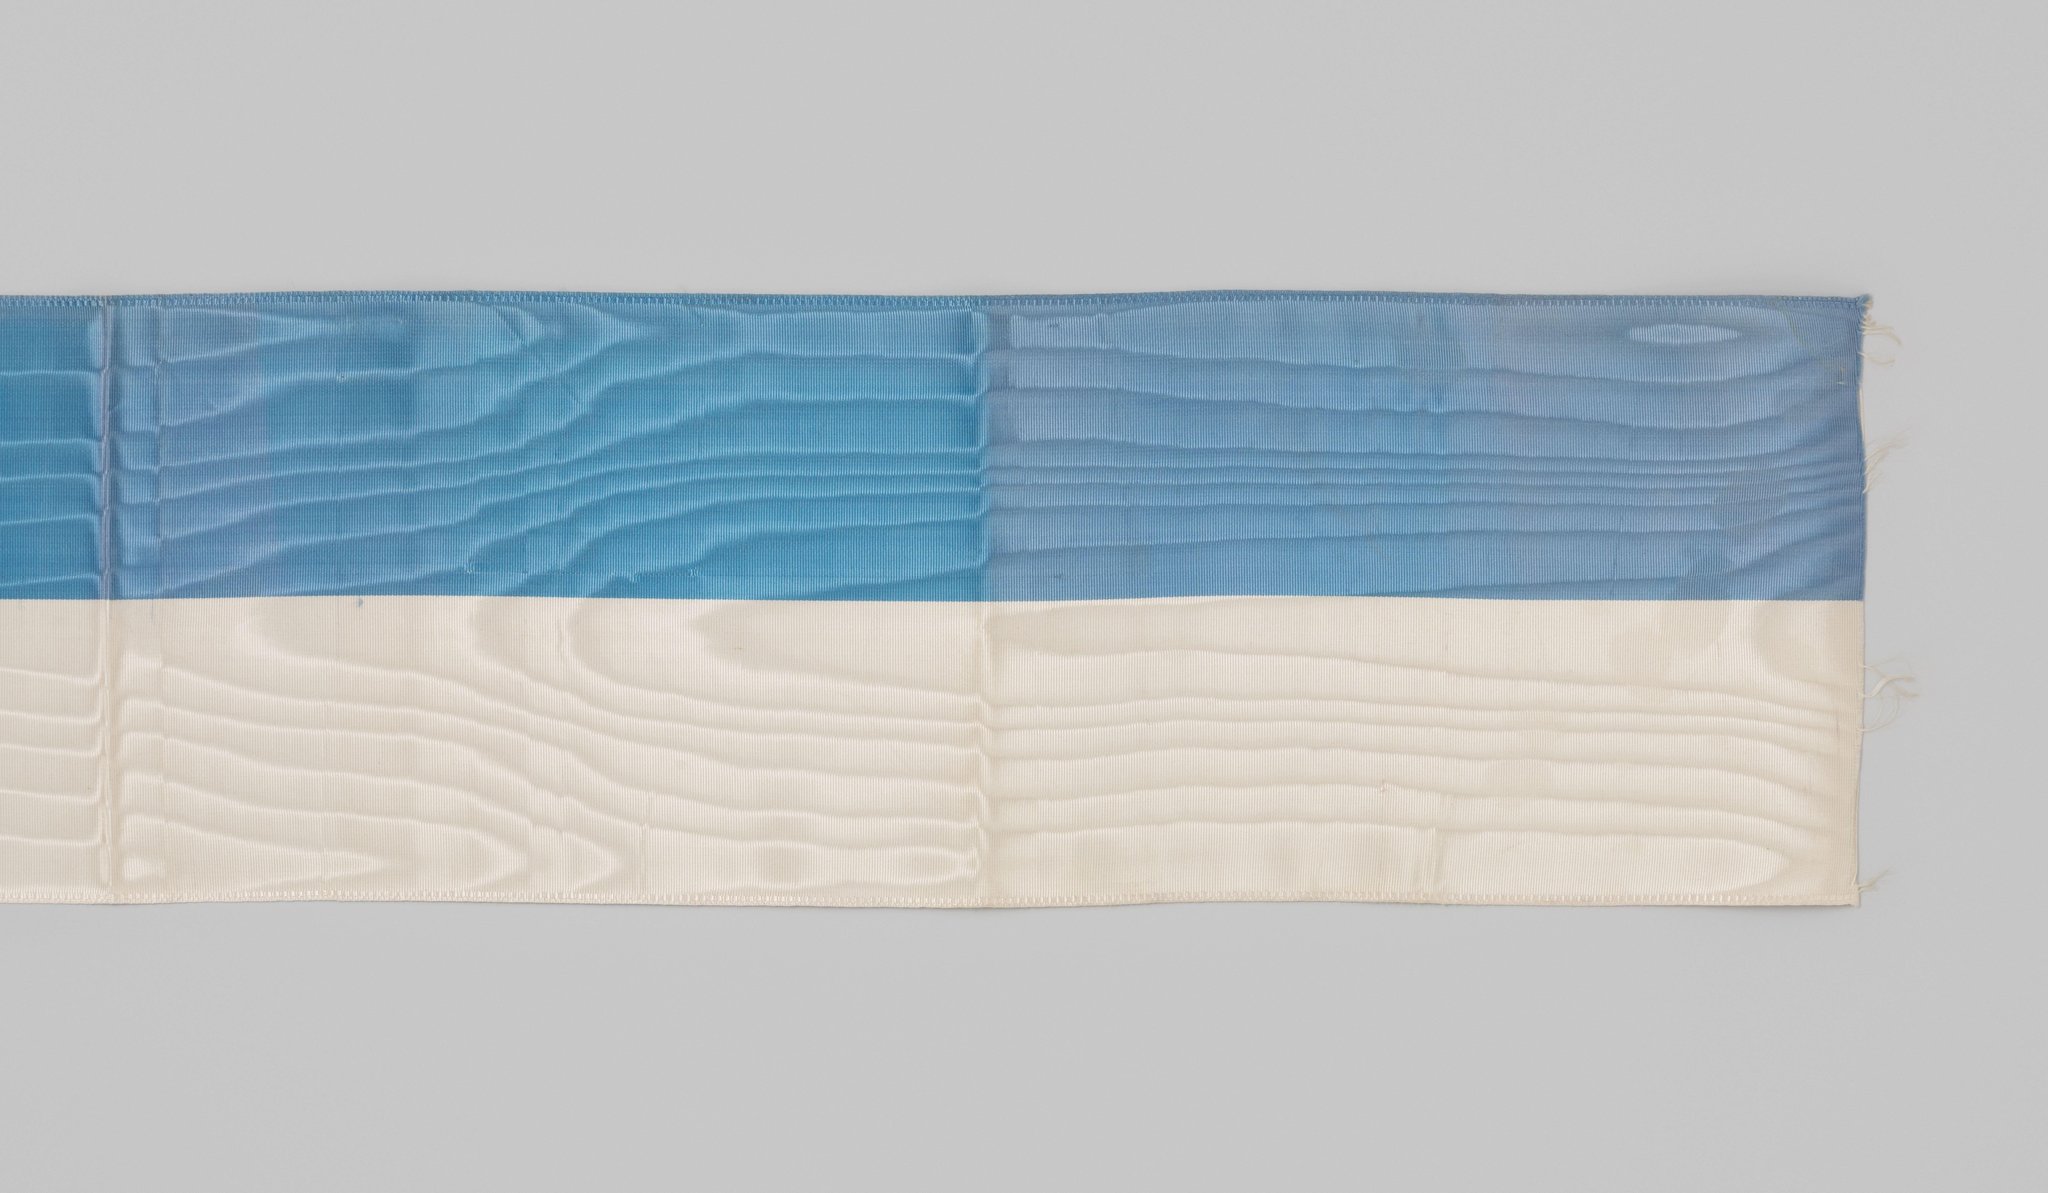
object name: ribbon material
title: Lint van moiré zijde dat over de lengte is verdeeld in een blauwe en een witte baan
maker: Anonymous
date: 1900-1950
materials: silk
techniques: moire, weave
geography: western europe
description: Verzameling zijden linten in terra/wit, arise/bruin, champagne, blauw-wit gestreept, mosgroen, marine, paars en zwart.